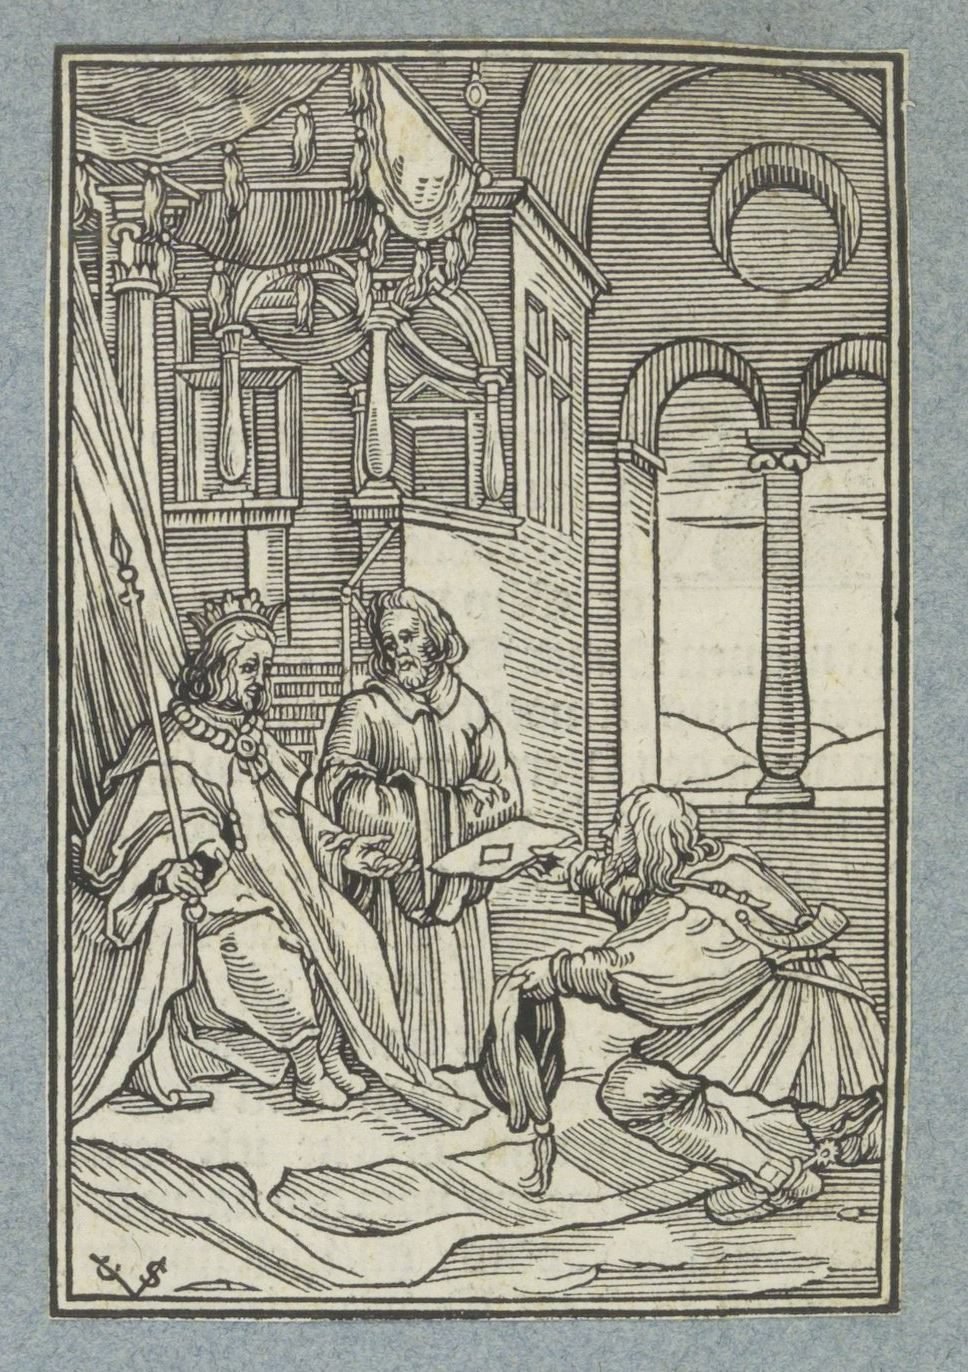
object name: album leaf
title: Afgezant van koning Chiram met boodschap voor Salomo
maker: pieter jacobsz. paets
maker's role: publisher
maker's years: 1587-1667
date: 1645-1646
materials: paper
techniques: letterpress printing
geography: amsterdam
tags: king hiram of tyre sends ambassadors to solomon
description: De prent werd gemaakt voor de uitgaven van P.J. Paets uit Amsterdam. Ze komt in ieder geval voor in: Bibels Tresoor ofte der zielen lusthof. Amsterdam, P.J. Paets, 1646. Mogelijk ook in: Historien ende Prophetien. [Amsterdam], P.J. Paets, 1645.